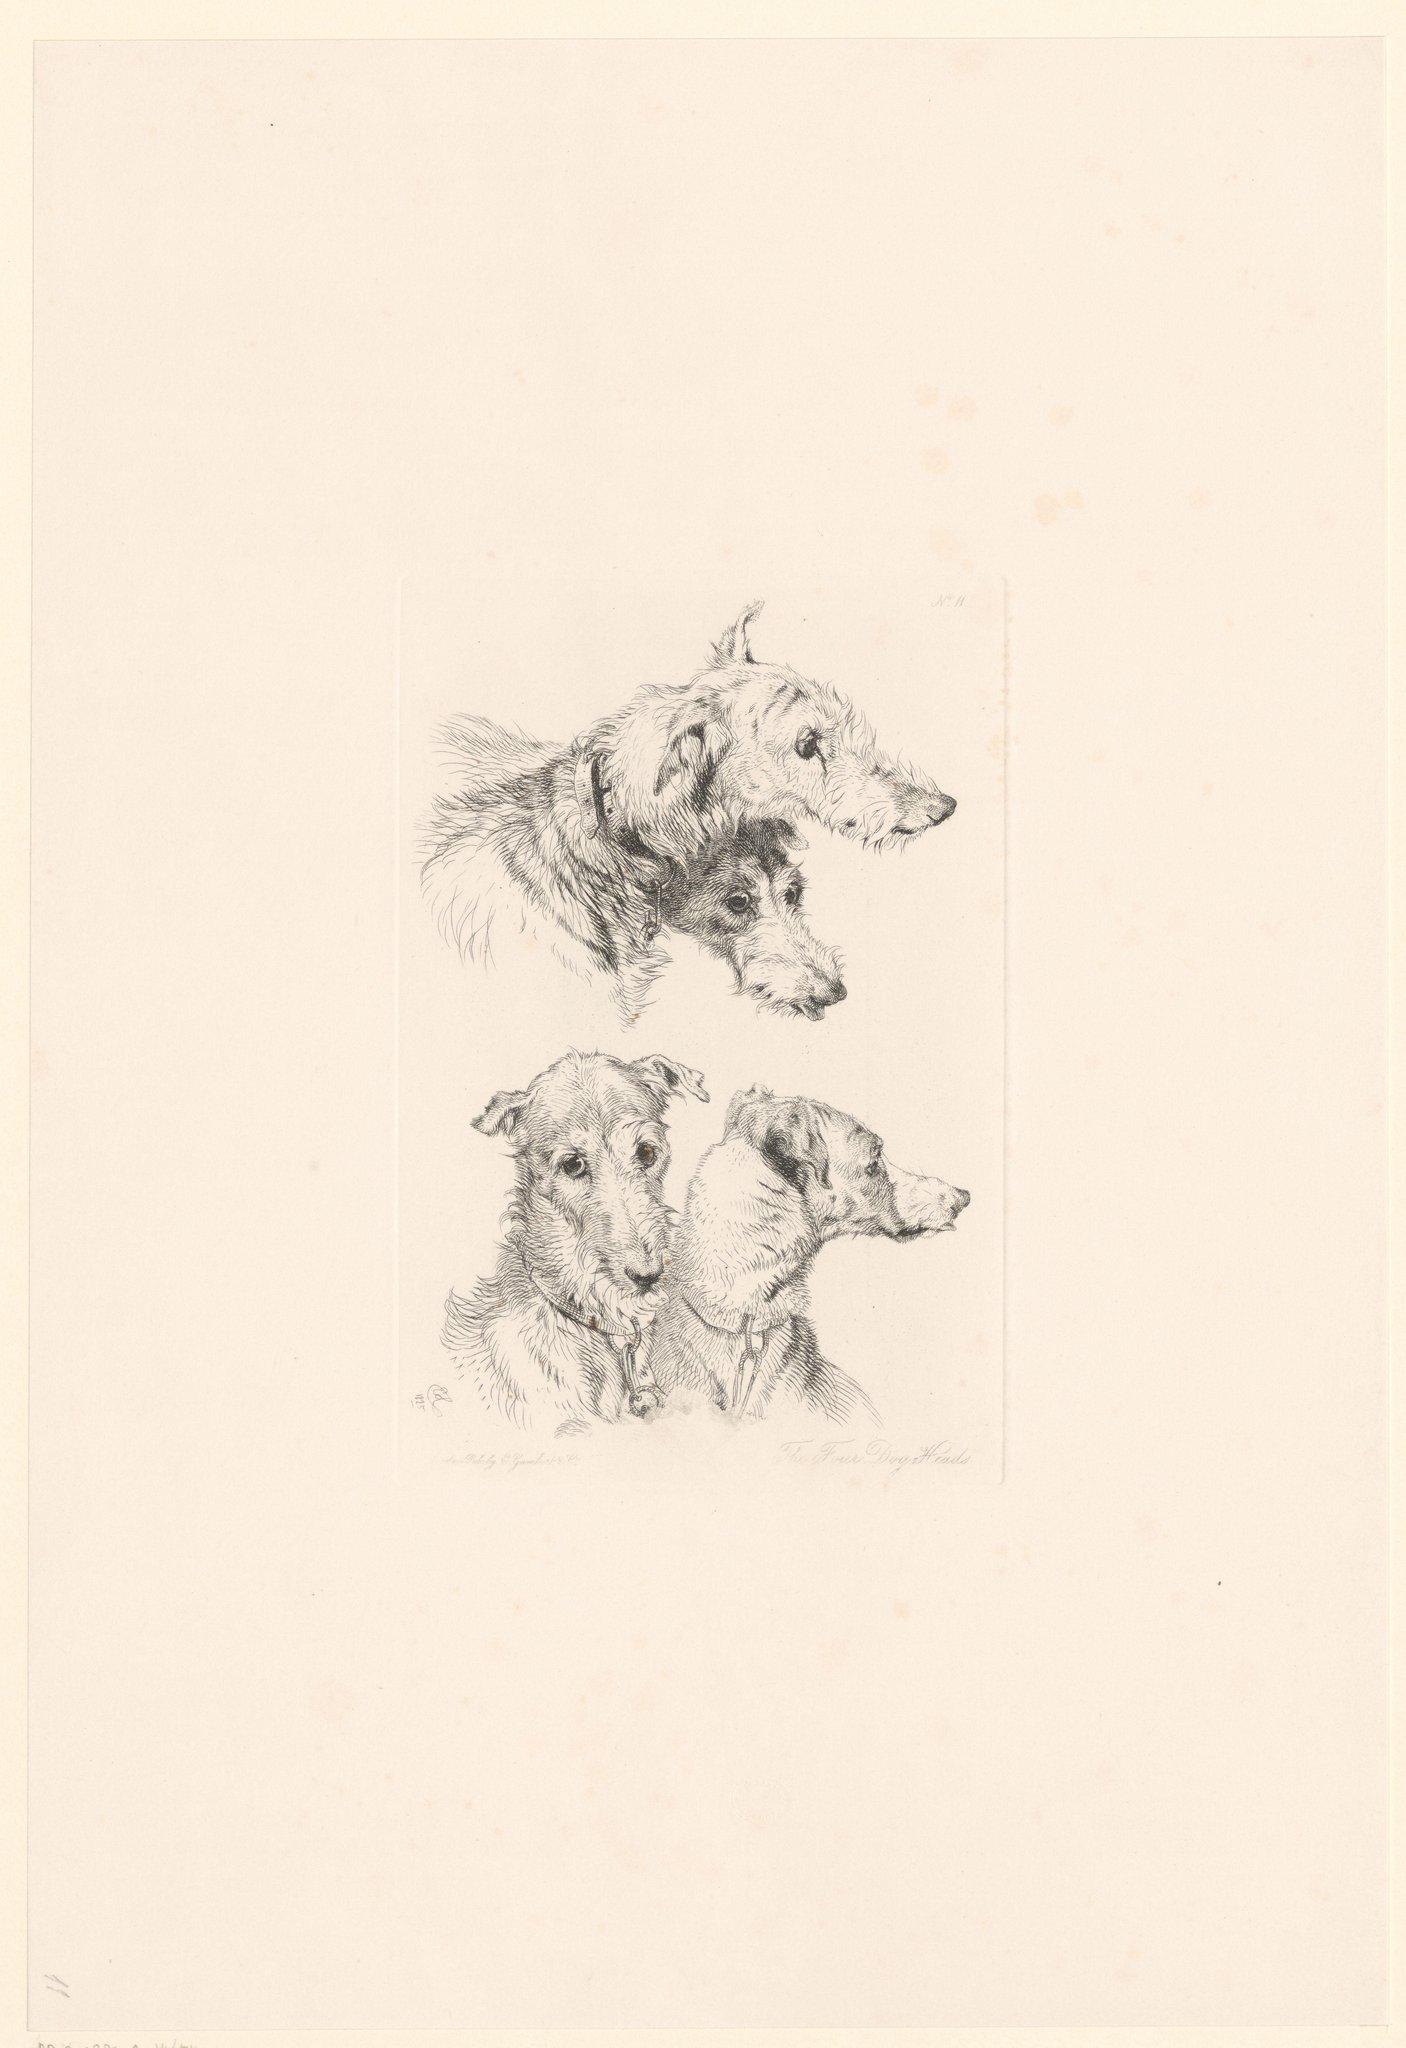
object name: print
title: Vier hondenkoppen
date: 1825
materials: paper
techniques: etching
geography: london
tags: dog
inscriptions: collector's mark: Lugt 2228, check stamp: Lugt 4736